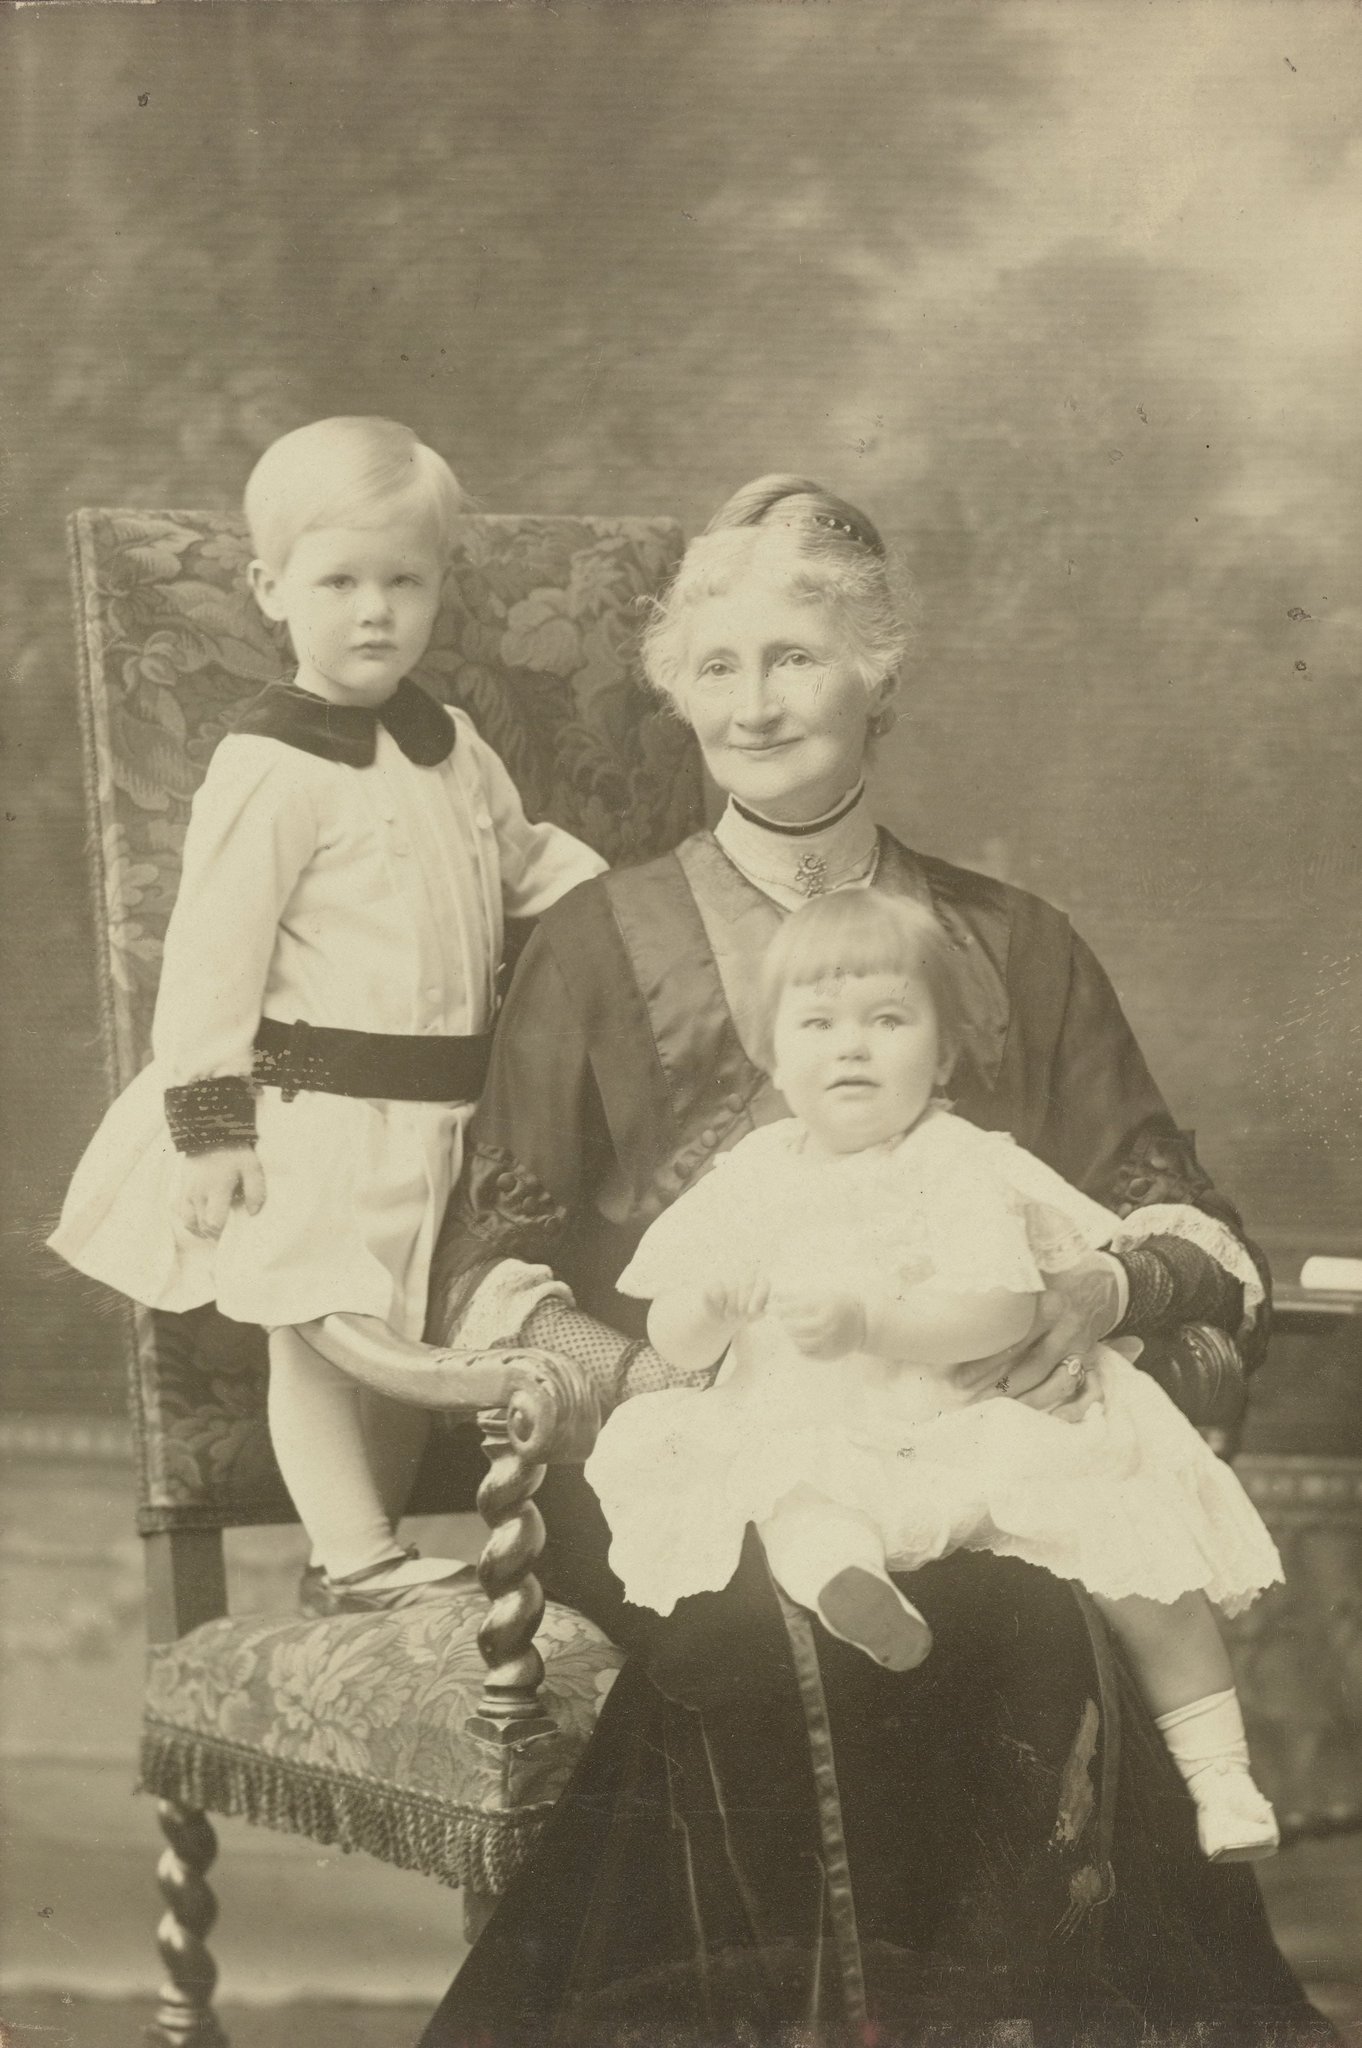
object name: photograph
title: Portret van Oma Boelen met Henk en Eva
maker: Anonymous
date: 1911-1914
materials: paper, photographic support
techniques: gelatin silver print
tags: eva charlotte pennink-boelen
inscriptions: inscription: ‘Oma Boelen met Henk en Eva’